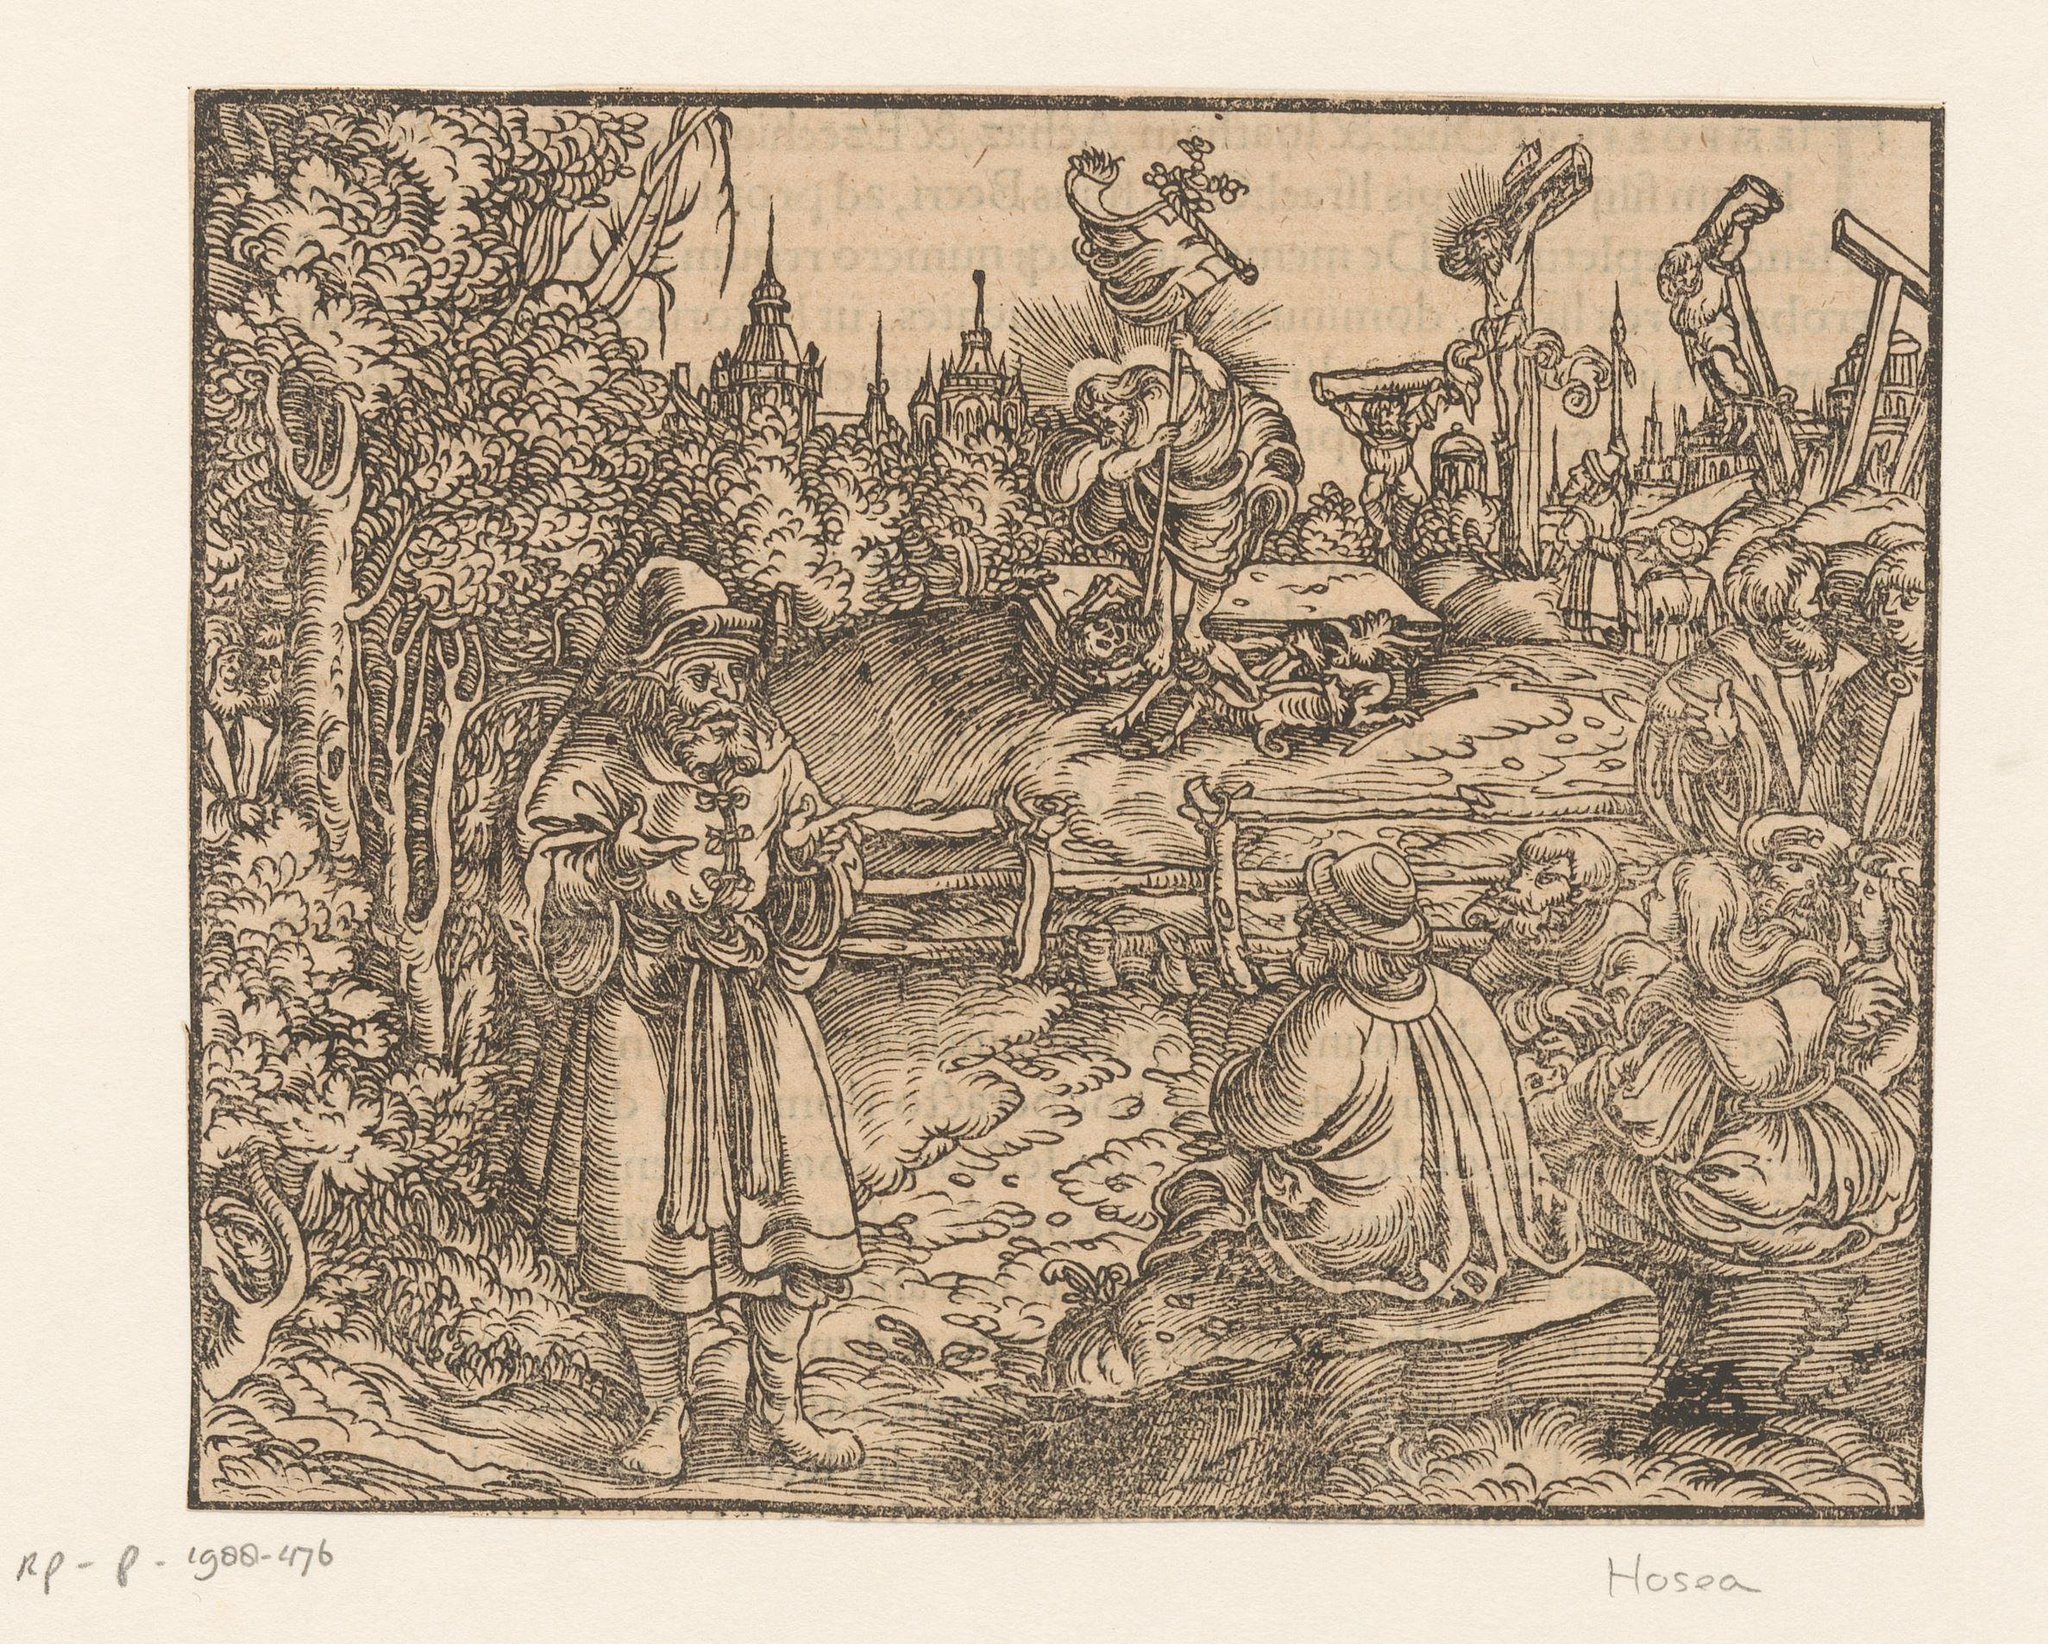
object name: print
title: Profeet Hosea predikend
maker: Anonymous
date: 1534-1600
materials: paper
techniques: woodcut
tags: the book of hosea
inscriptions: collector's mark: Lugt 2228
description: Prent afkomstig uit een onbekende publicatie.